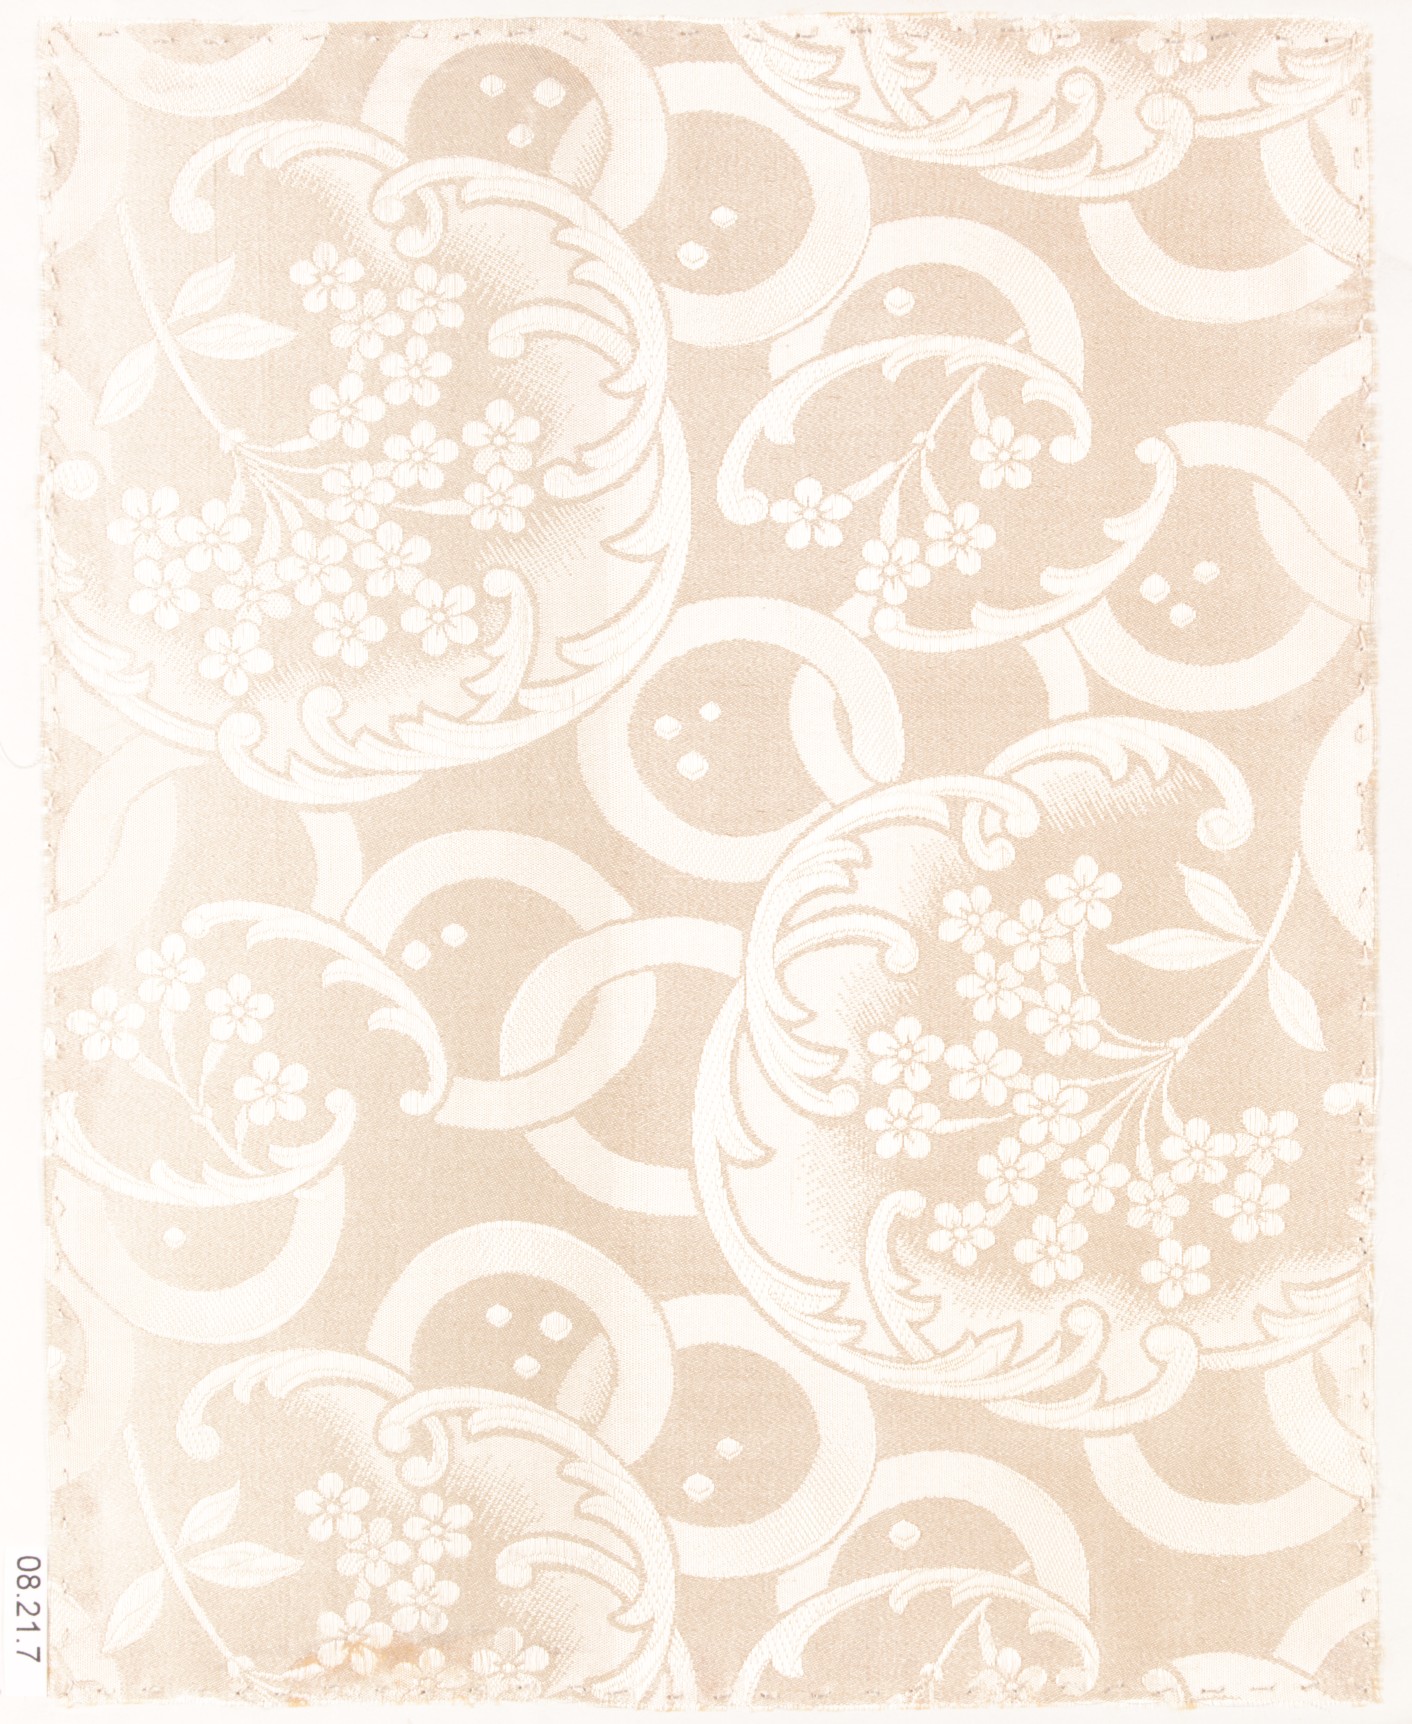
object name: textile sample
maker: Anonymous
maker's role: designer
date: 1900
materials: silk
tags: flowers